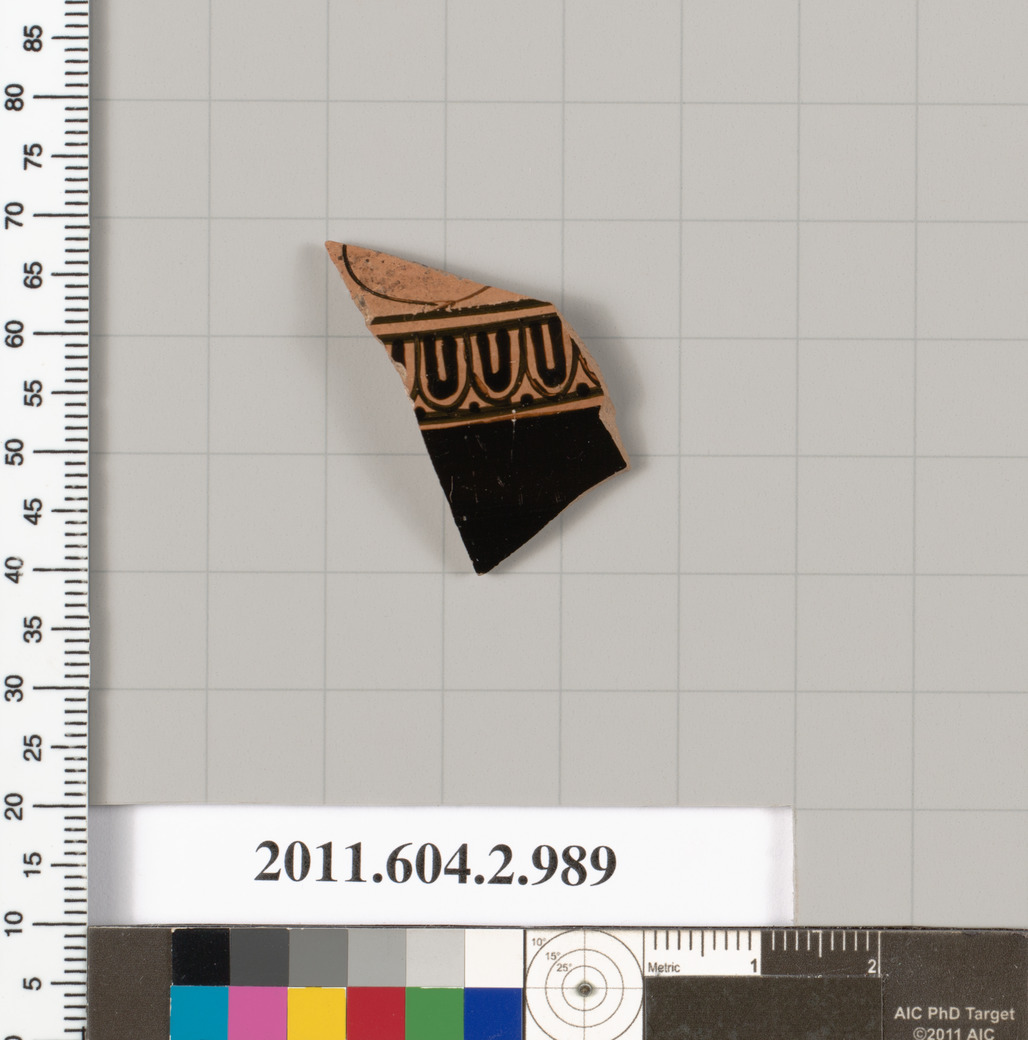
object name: oinochoe fragment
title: Terracotta fragment of an oinochoe (jug)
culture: greek, attic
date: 460-440 BCE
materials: terracotta